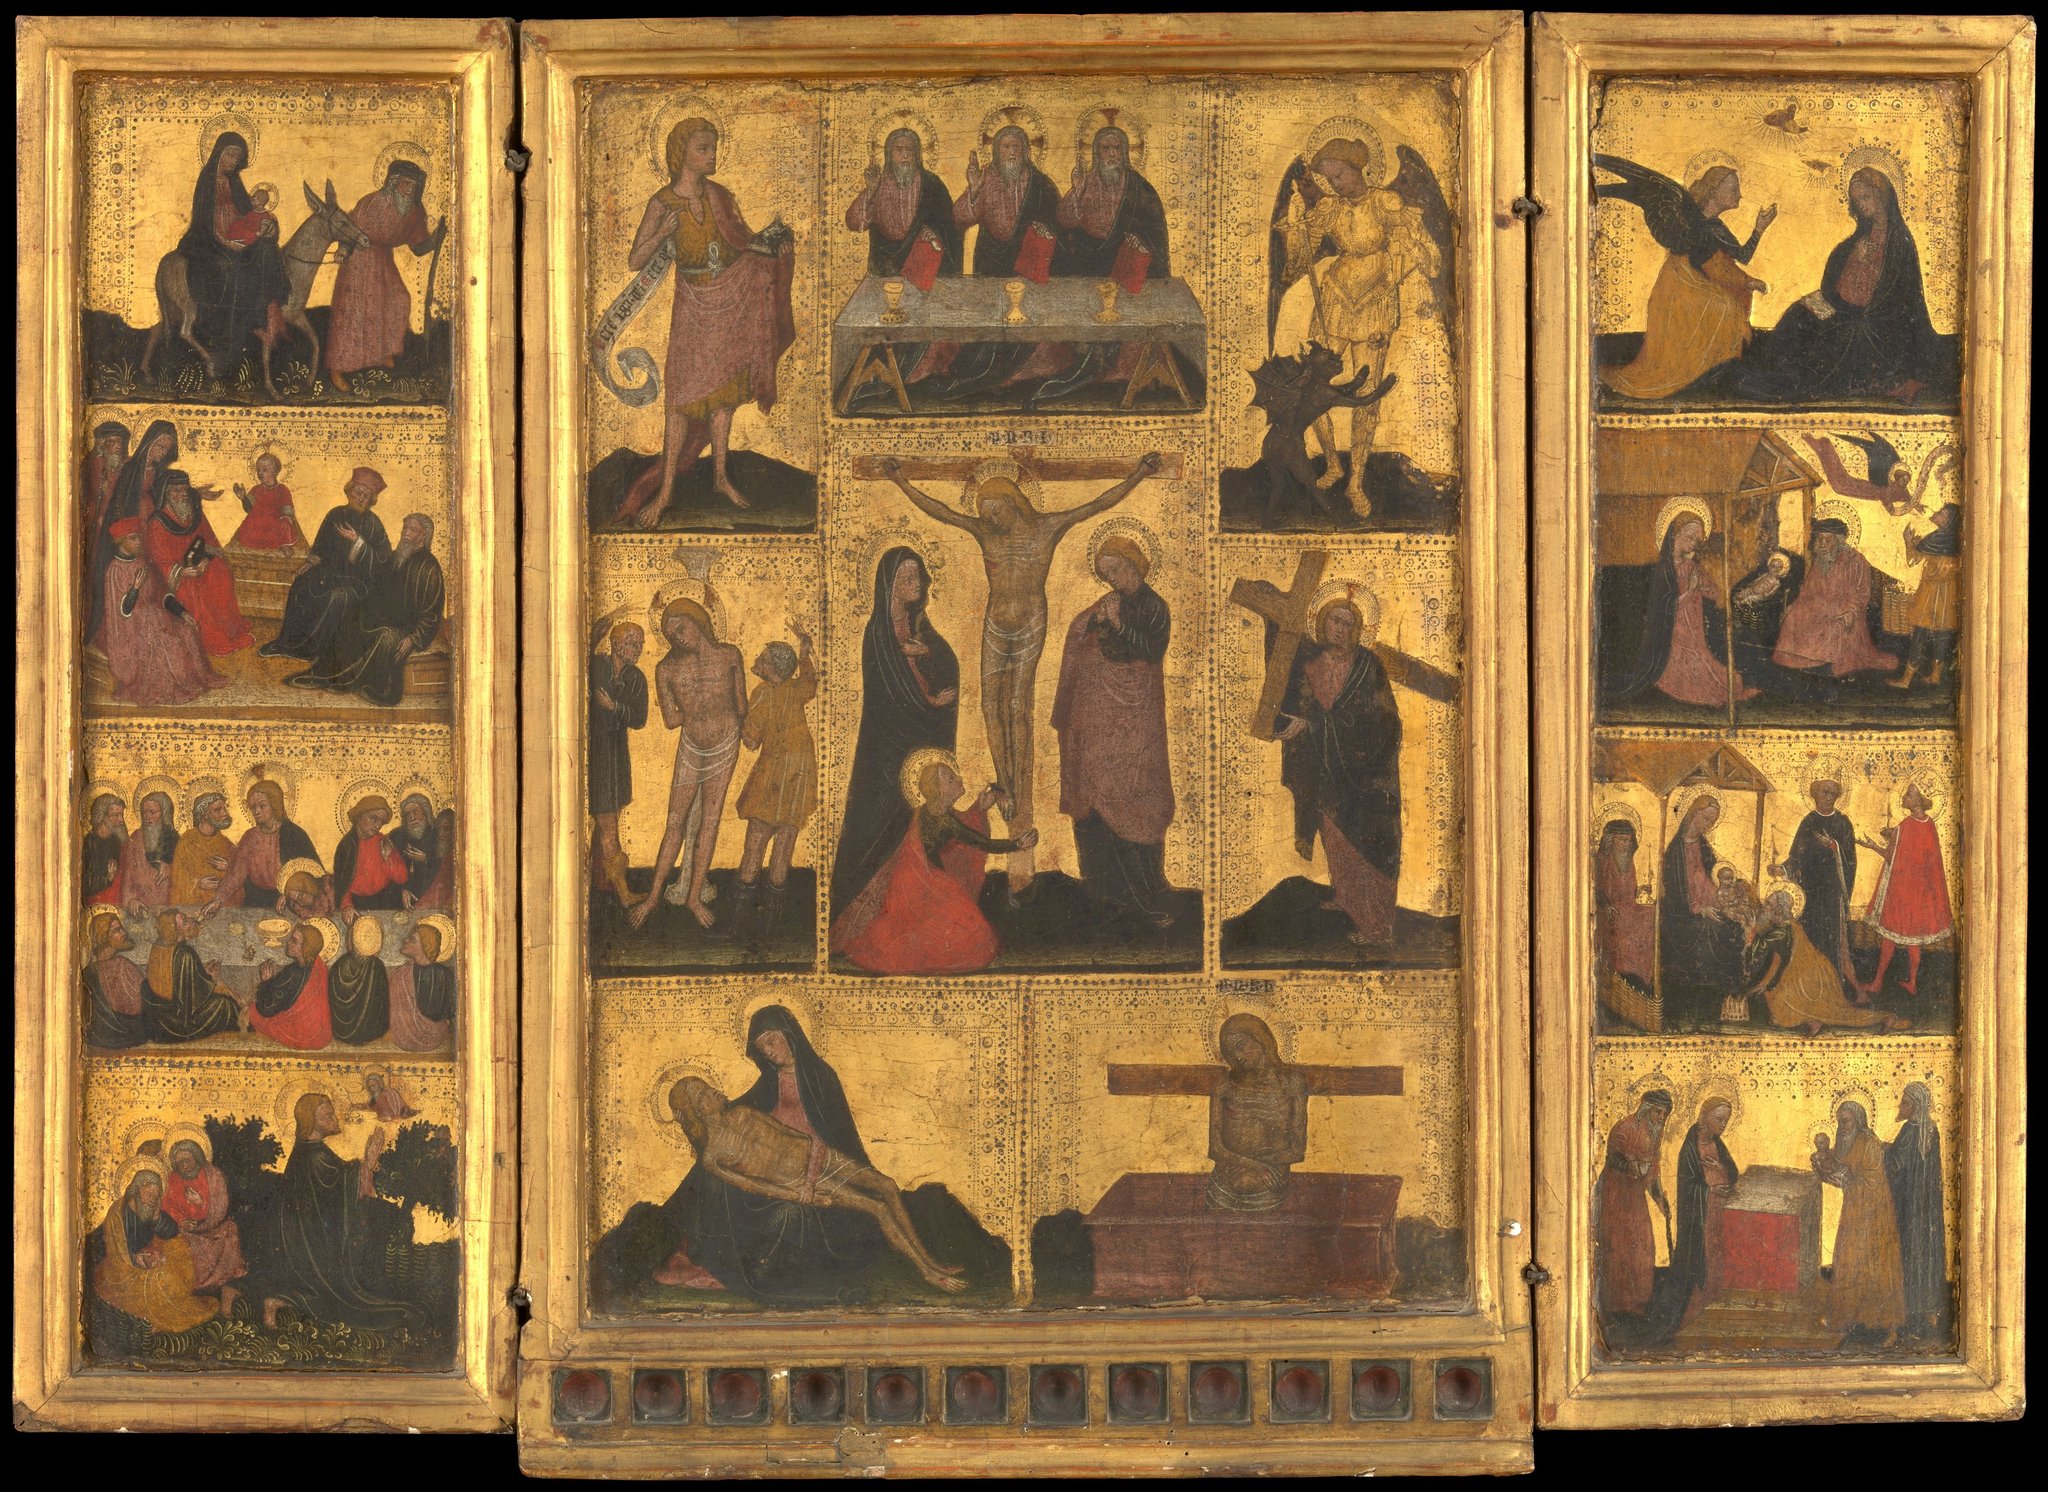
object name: painting, triptych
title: The Life of Christ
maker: franceschino zavattari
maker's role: artist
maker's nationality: italian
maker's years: 1414-1453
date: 1400-1449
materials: gold leaf, paint, wood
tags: christ,saint john the baptist,adoration of the magi,last supper,nativity,flight into egypt